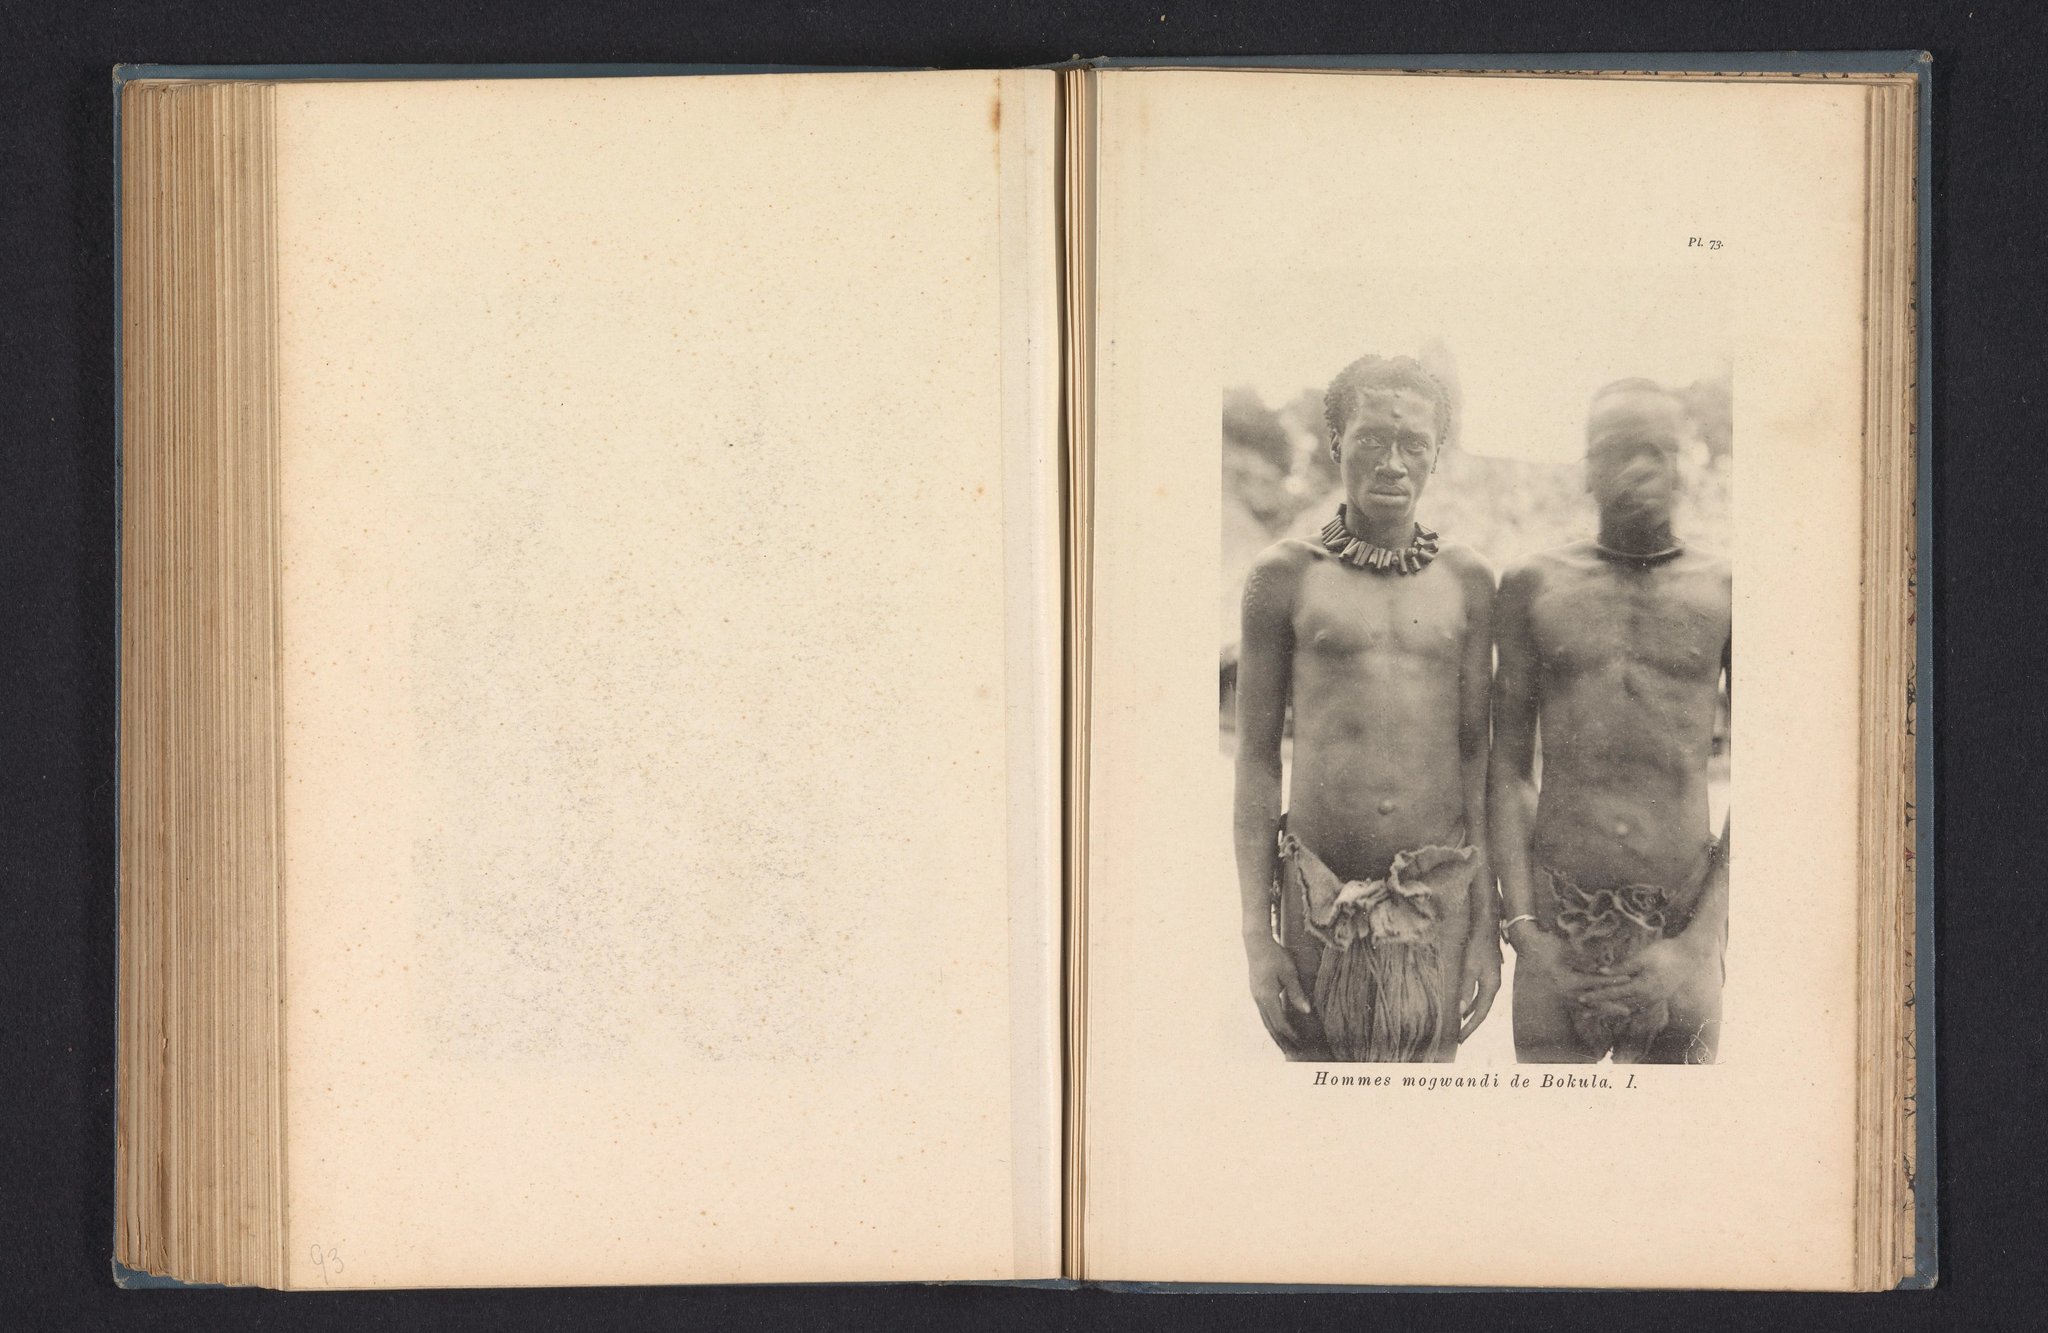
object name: page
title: Hommes mogwandi de Bokula I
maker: franz thonner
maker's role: botanicus, ontdekkingsreiziger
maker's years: 1863-1928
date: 1896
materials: paper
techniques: photograph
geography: bokula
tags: adult man, necklace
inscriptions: number: ‘Pl. 73.’